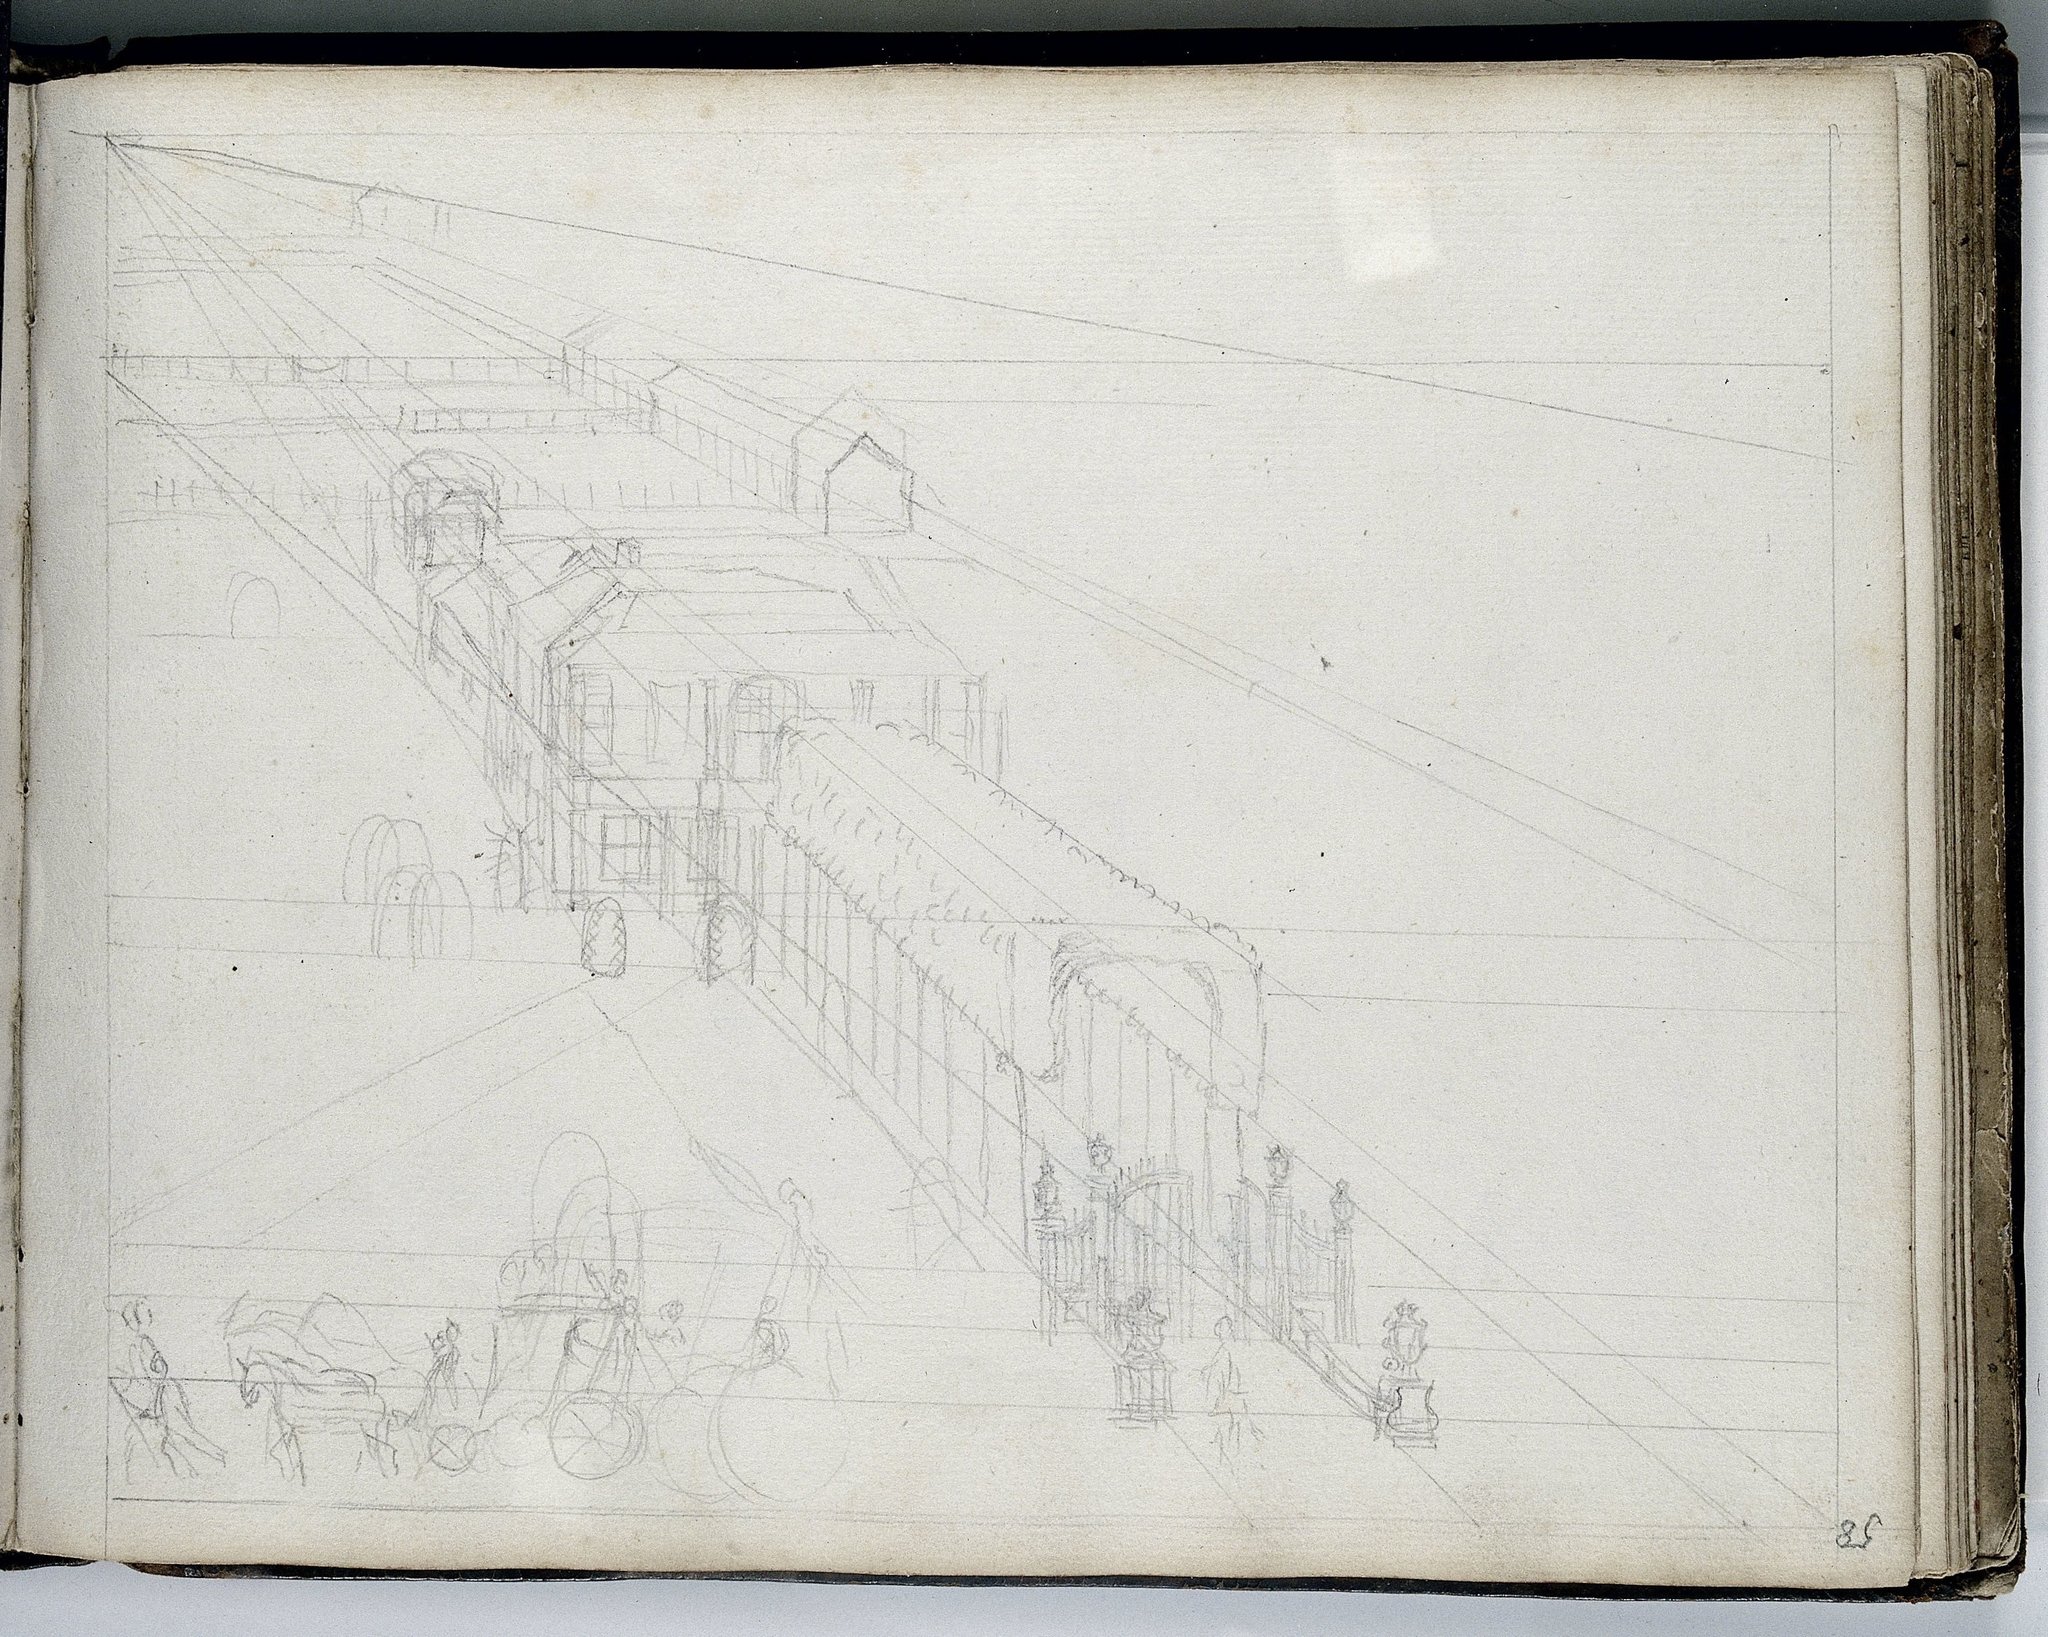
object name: perspective drawing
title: Het landgoed van Brandes bij Batavia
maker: jan brandes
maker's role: draughtsman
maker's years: 1743-1808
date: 1787-1808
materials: paper, pencil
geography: skälsebo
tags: bodegraven, draughtsman, jan brandes, country-house, batavia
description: Perspectiefstudie. Potloodtekening van het huis met tuinen en bijgebouwen van Brandes' huis buiten Batavia van de voorzijde. Over de weg die voor het huis langs loopt, rijdt een rijtuig met passagier en een pajungdrager achterop. Het opschrift is van Kellberg, 20ste eeuwse nazaat van Brandes. Onderdeel uit het grote schetsboek van Jan Brandes 'Perspektivritningar' (1808), p. 58. (Deze tekening is een eerdere versie van 4-46 die aan de ommezijde staat.)